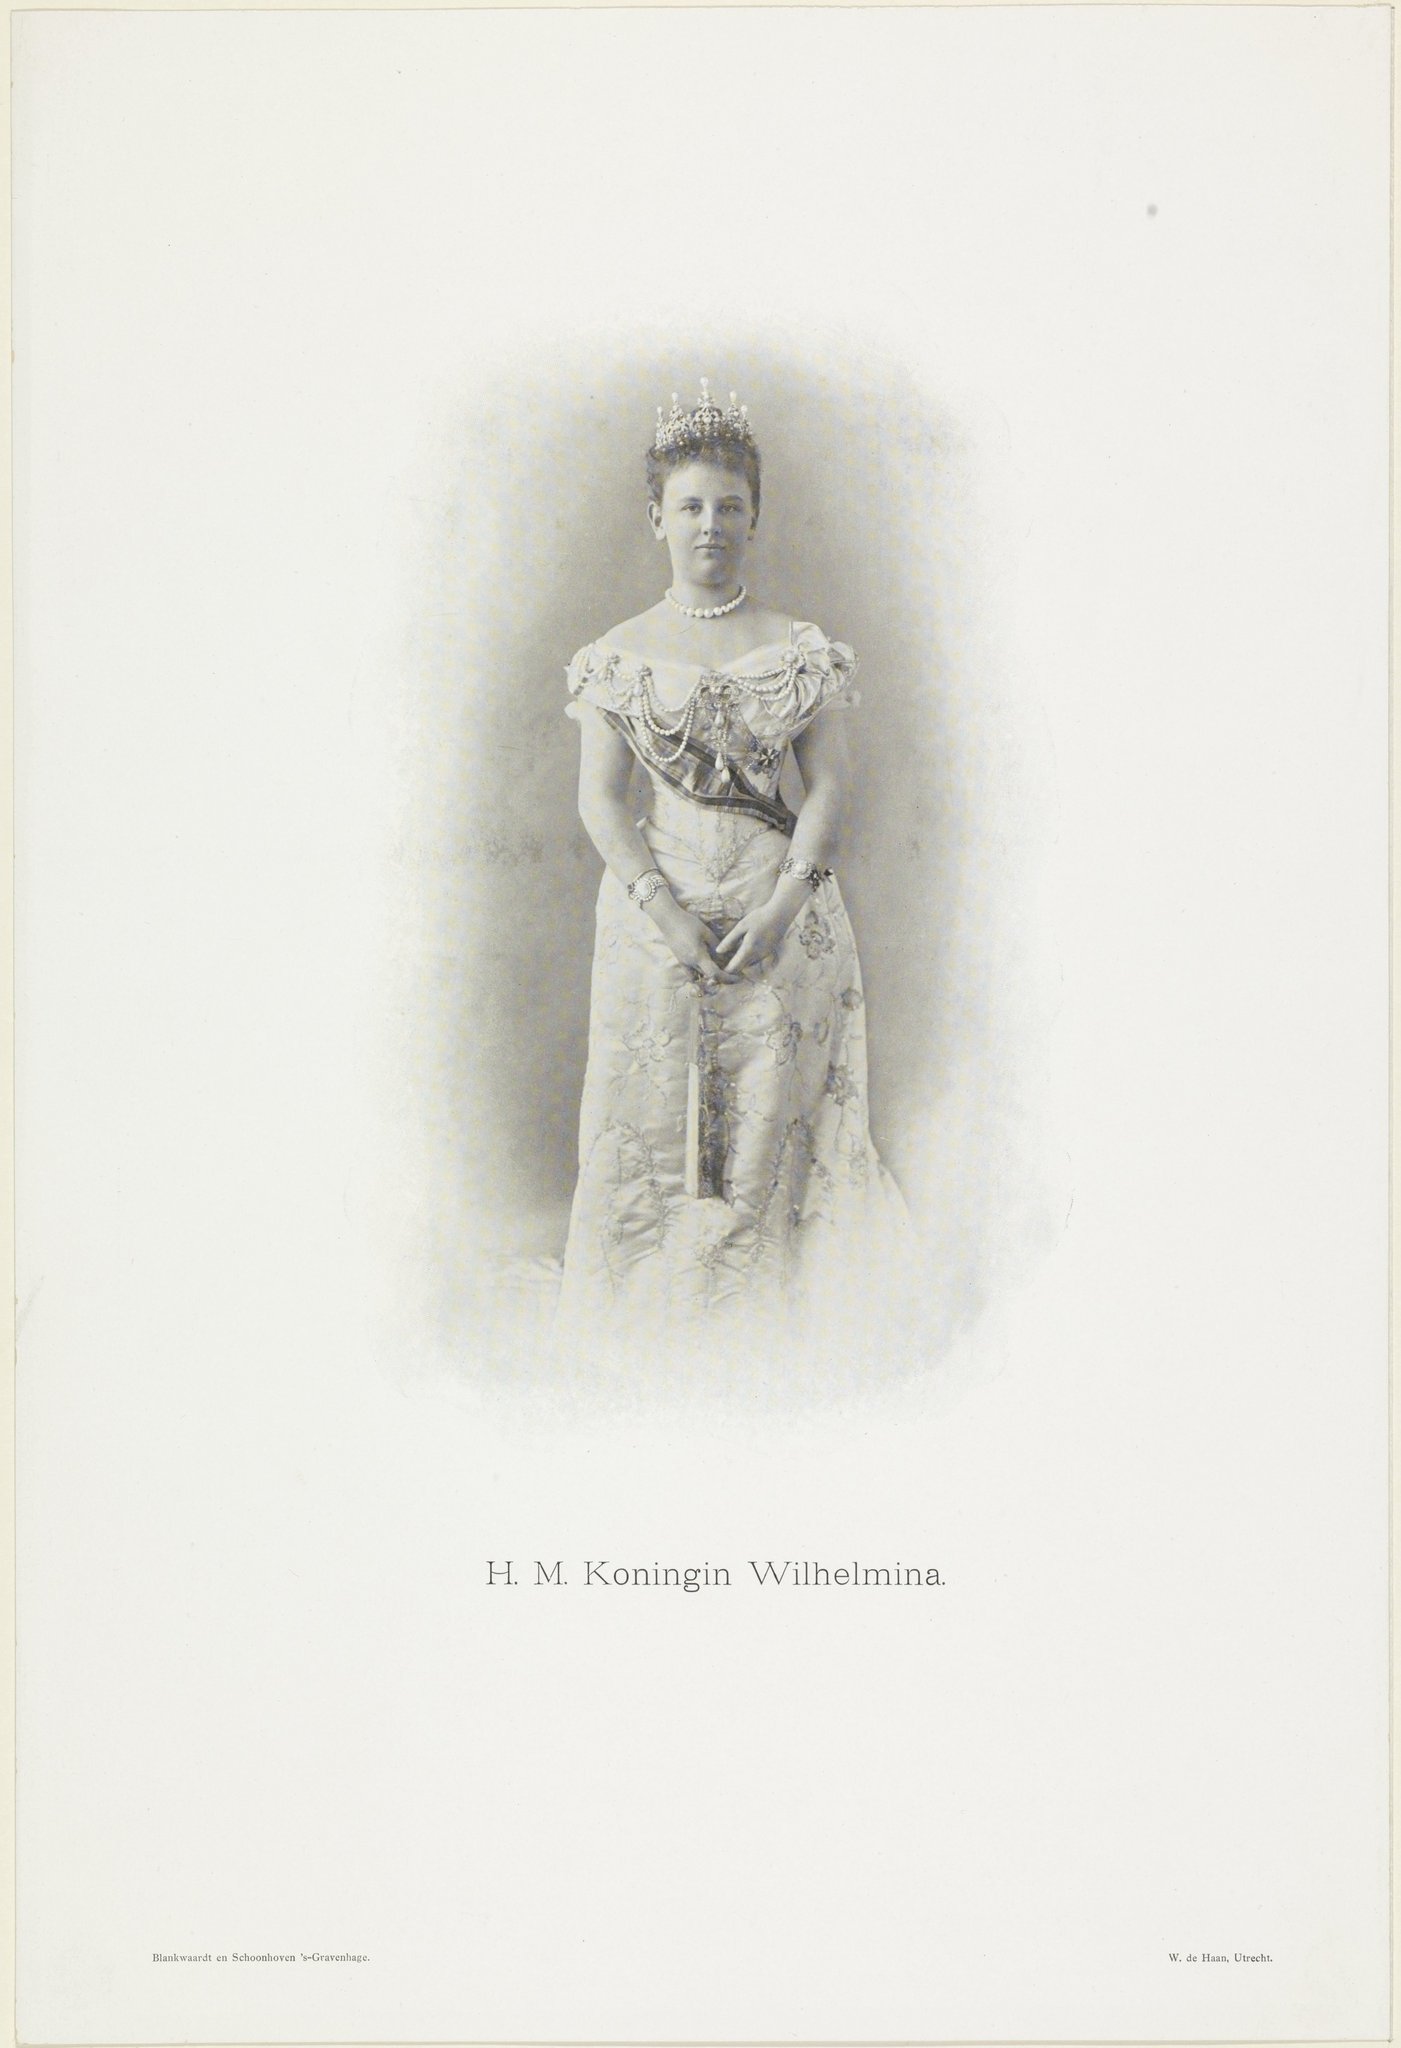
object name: photomechanical print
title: Portret van Wilhelmina, koningin der Nederlanden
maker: Anonymous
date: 1900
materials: paper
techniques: autotype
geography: netherlands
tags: print maker, wilhelmina of the netherlands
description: De hier vermelde titel verwijst naar de hoogst verkregen titel van de geportretteerde, niet per se naar de titel die de geportretteerde op deze voorstelling draagt.